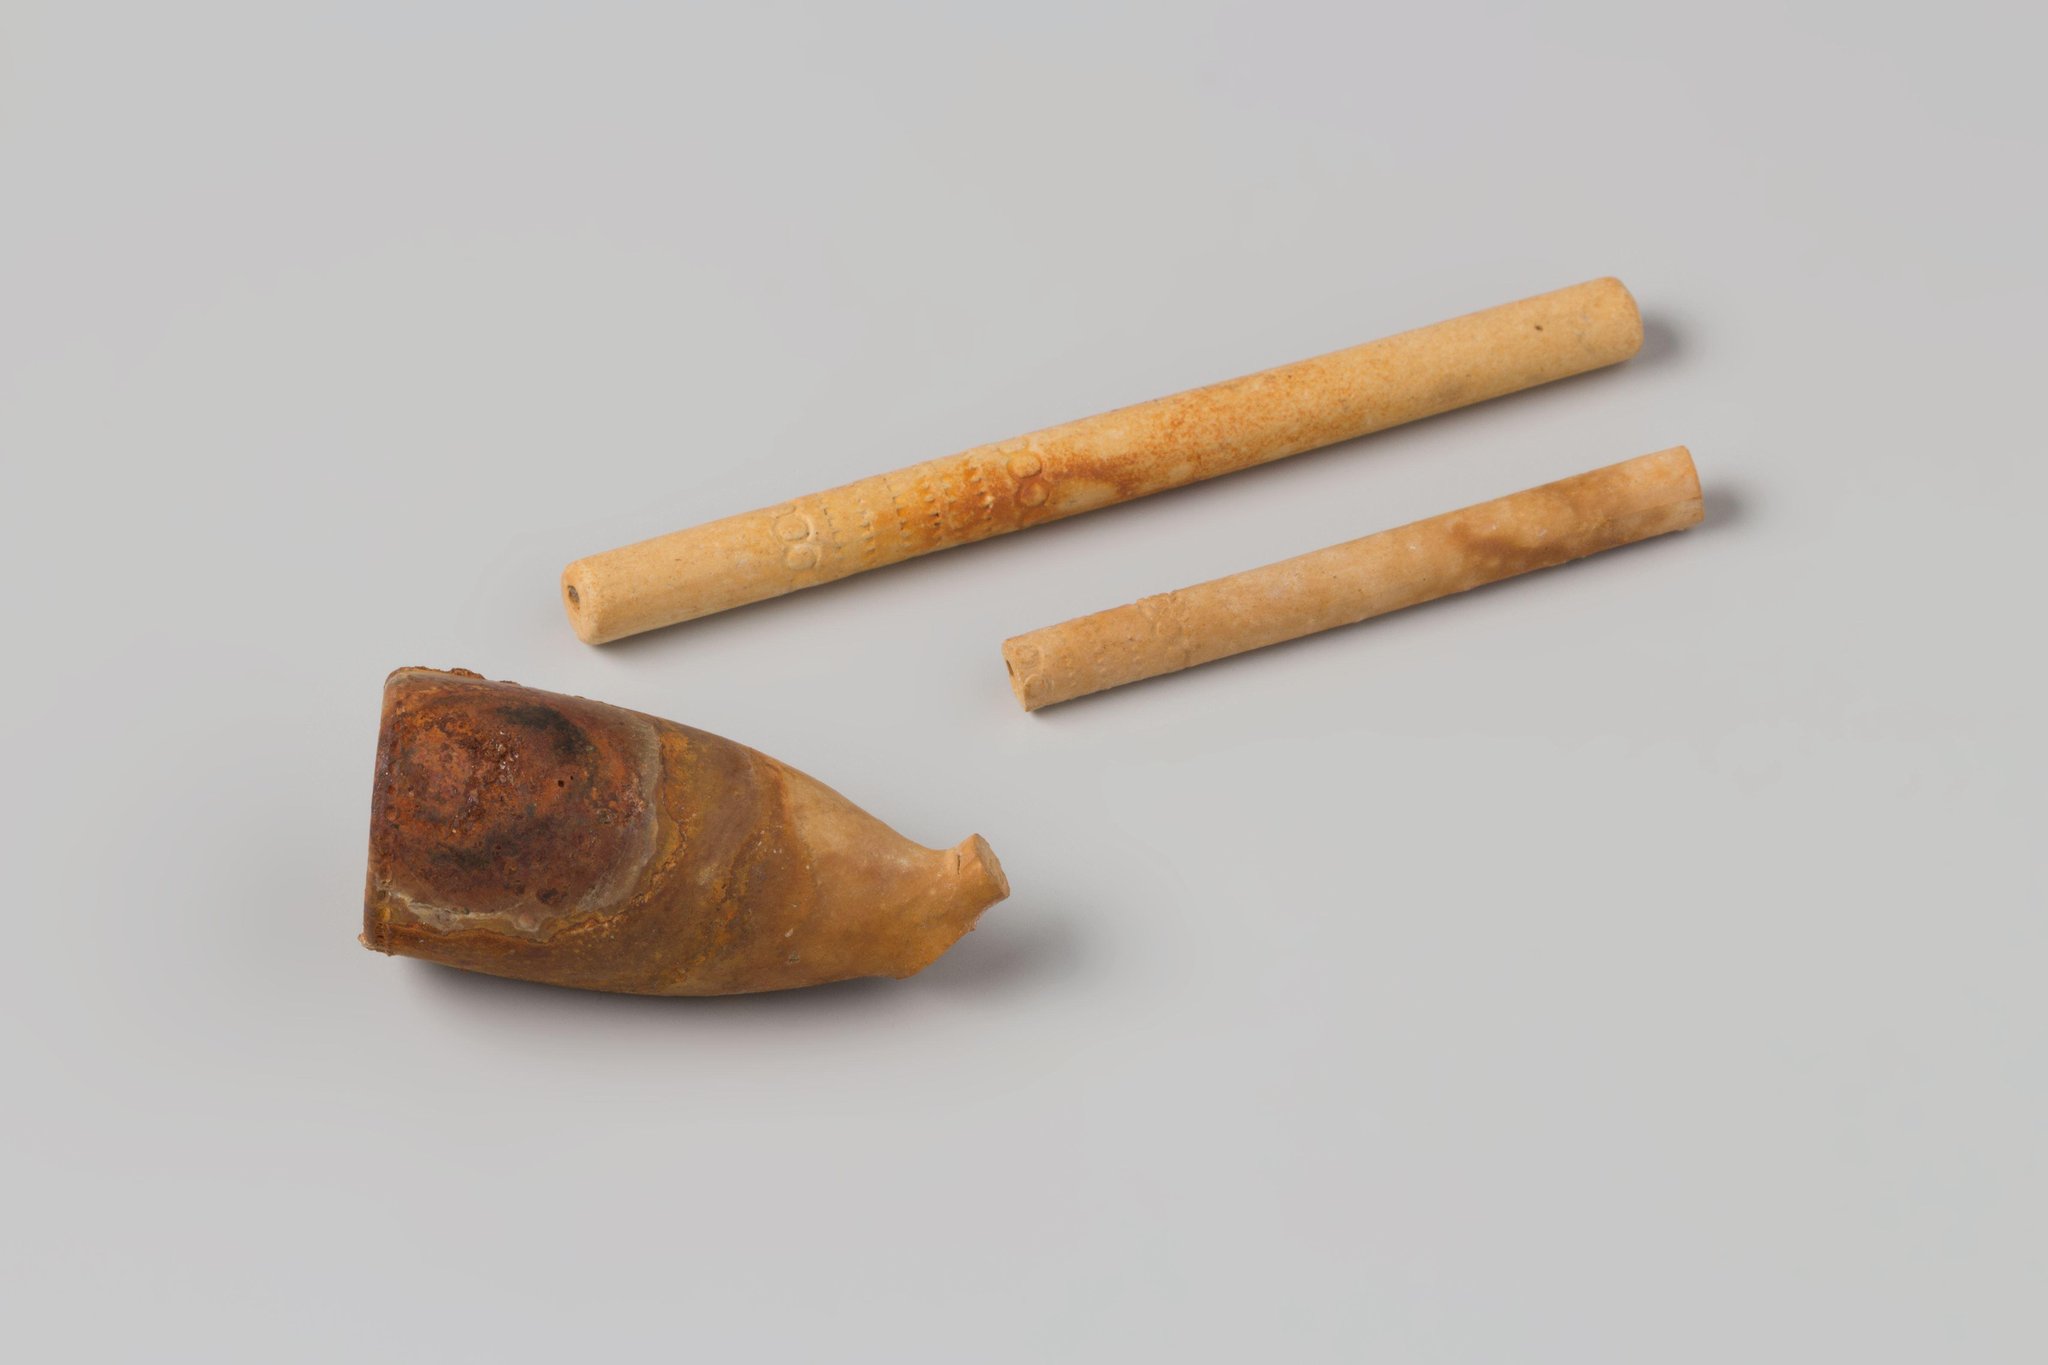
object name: pipe bowl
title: Pijpenkop en fragmenten pijpenstelen uit het wrak van de Oost-Indiëvaarder Hollandia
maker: Anonymous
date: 1700-1743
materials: clay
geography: netherlands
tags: verenigde oostindische compagnie, hollandia (schip), annet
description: Pipe, bowl, heelmark: crowned 82; no hsm.